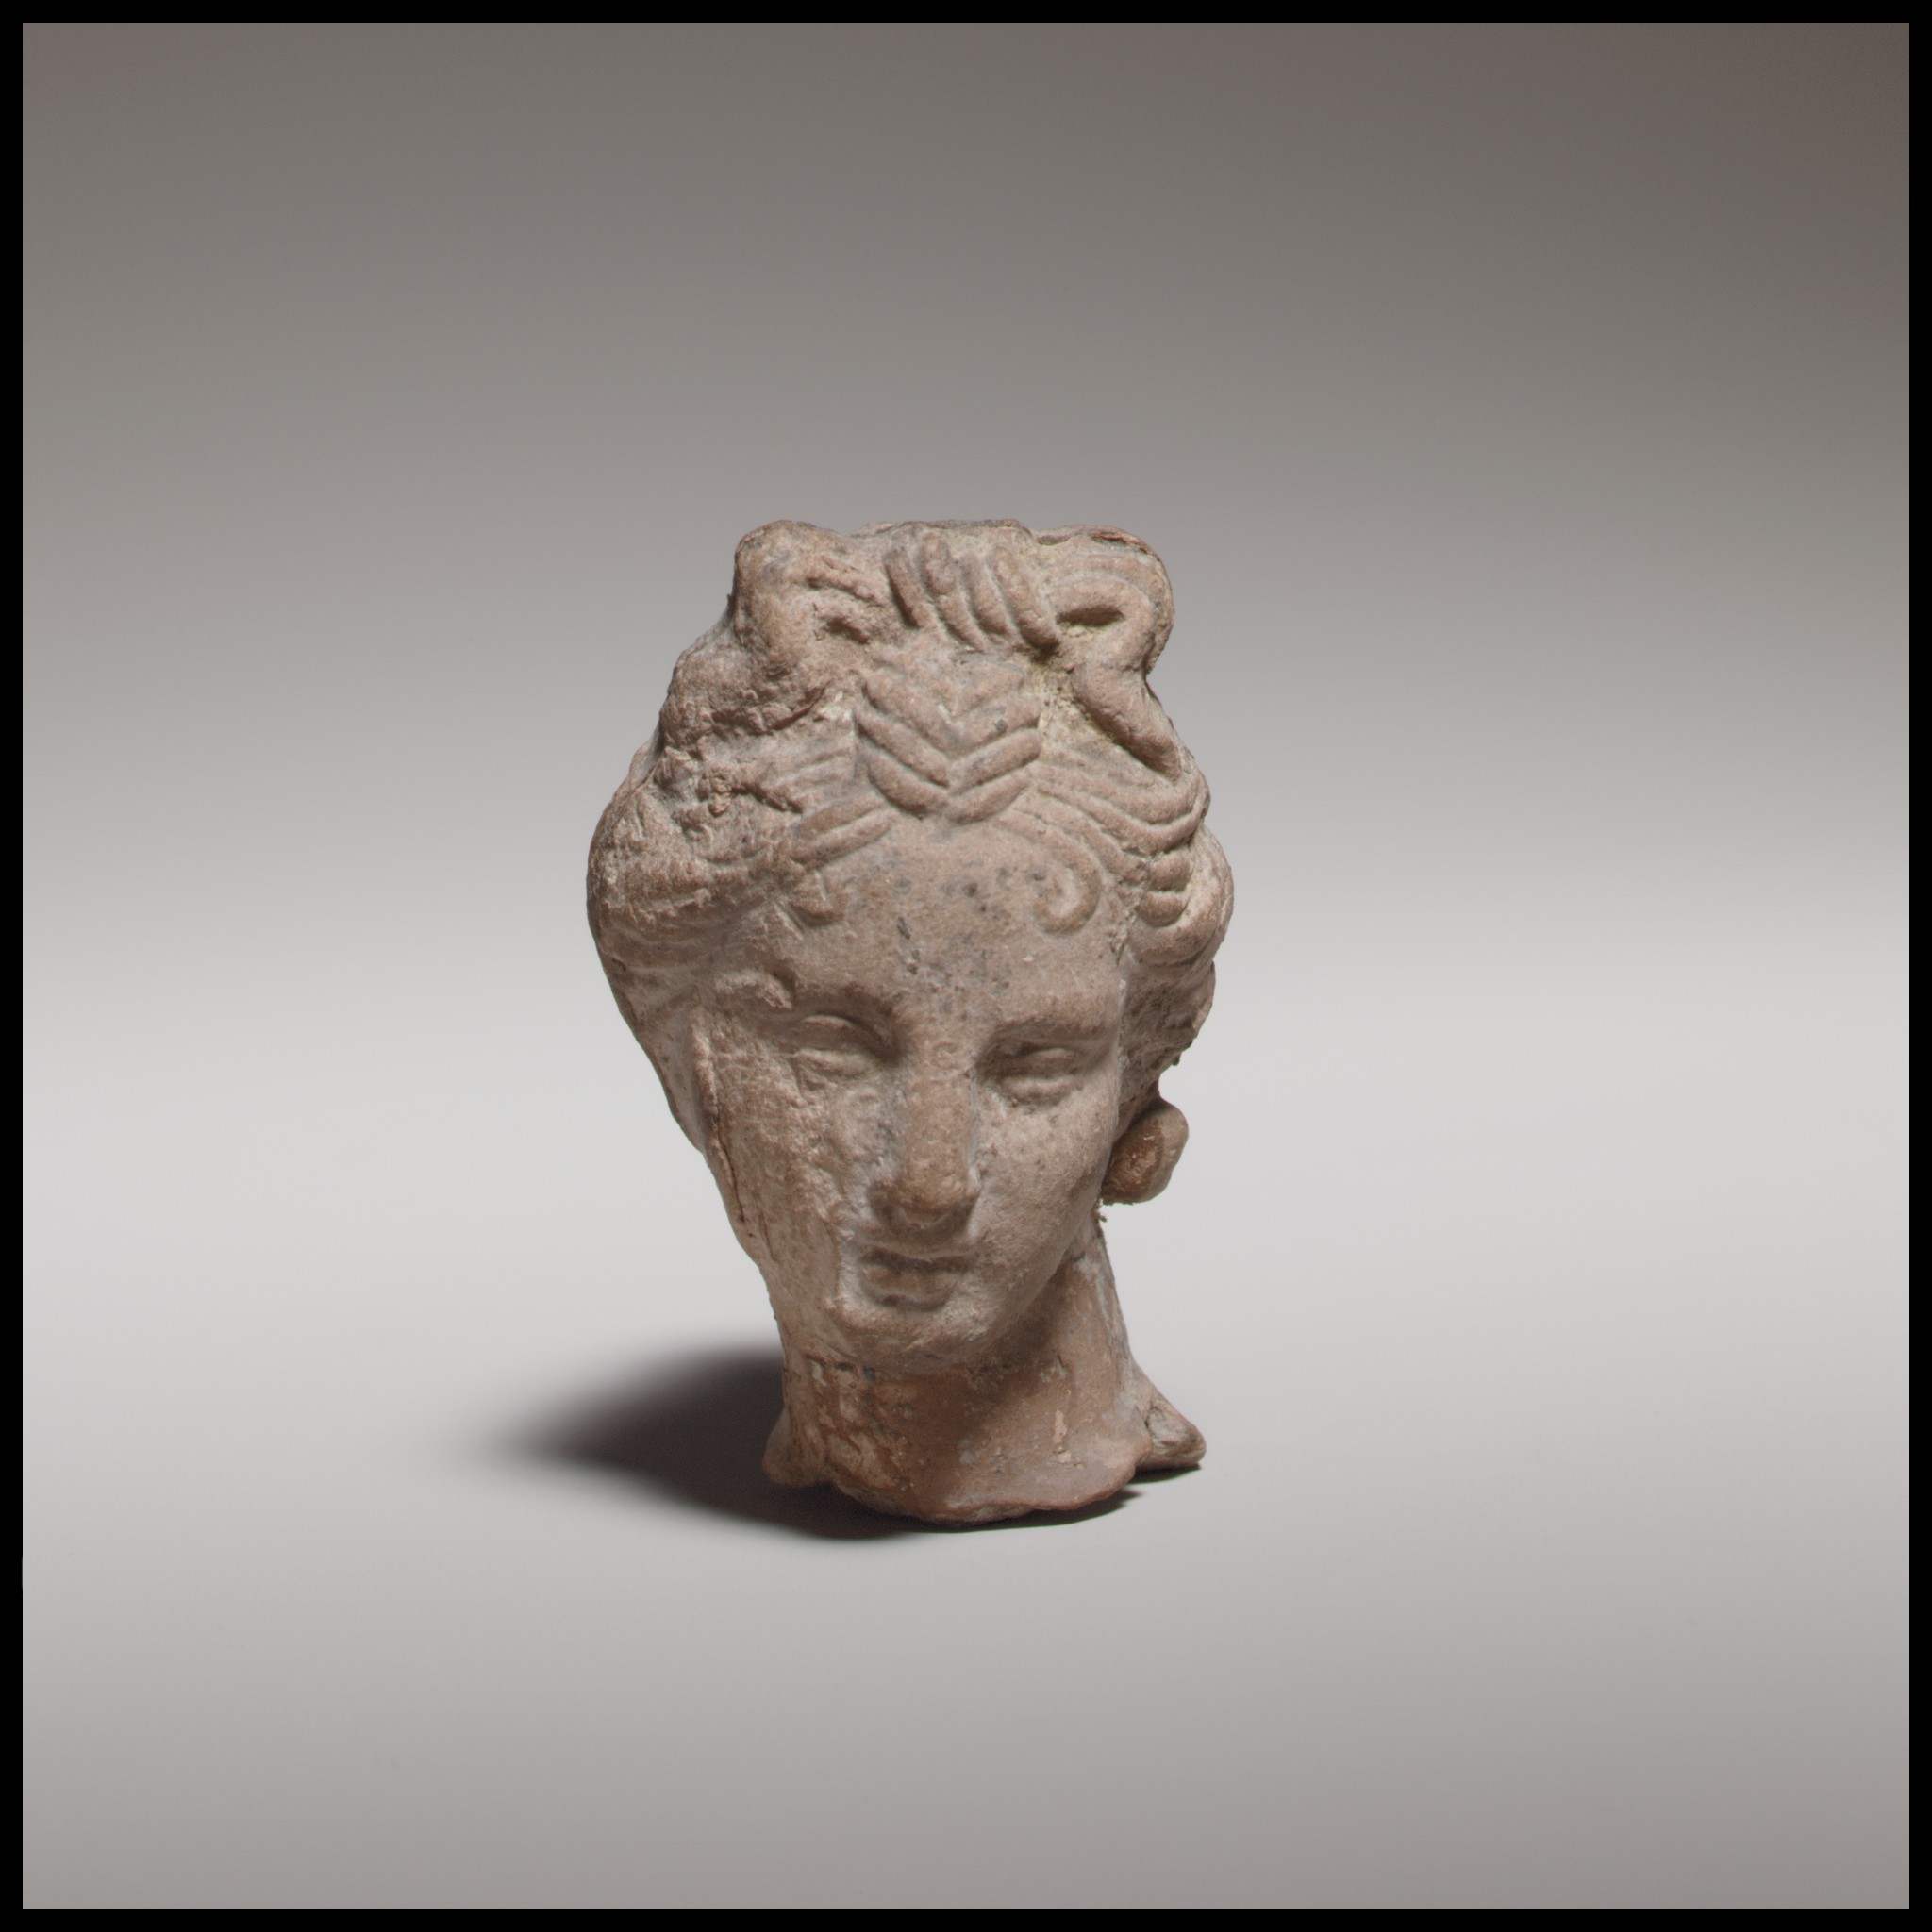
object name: head of a woman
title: Terracotta female head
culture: greek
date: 101-200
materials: terracotta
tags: heads,women